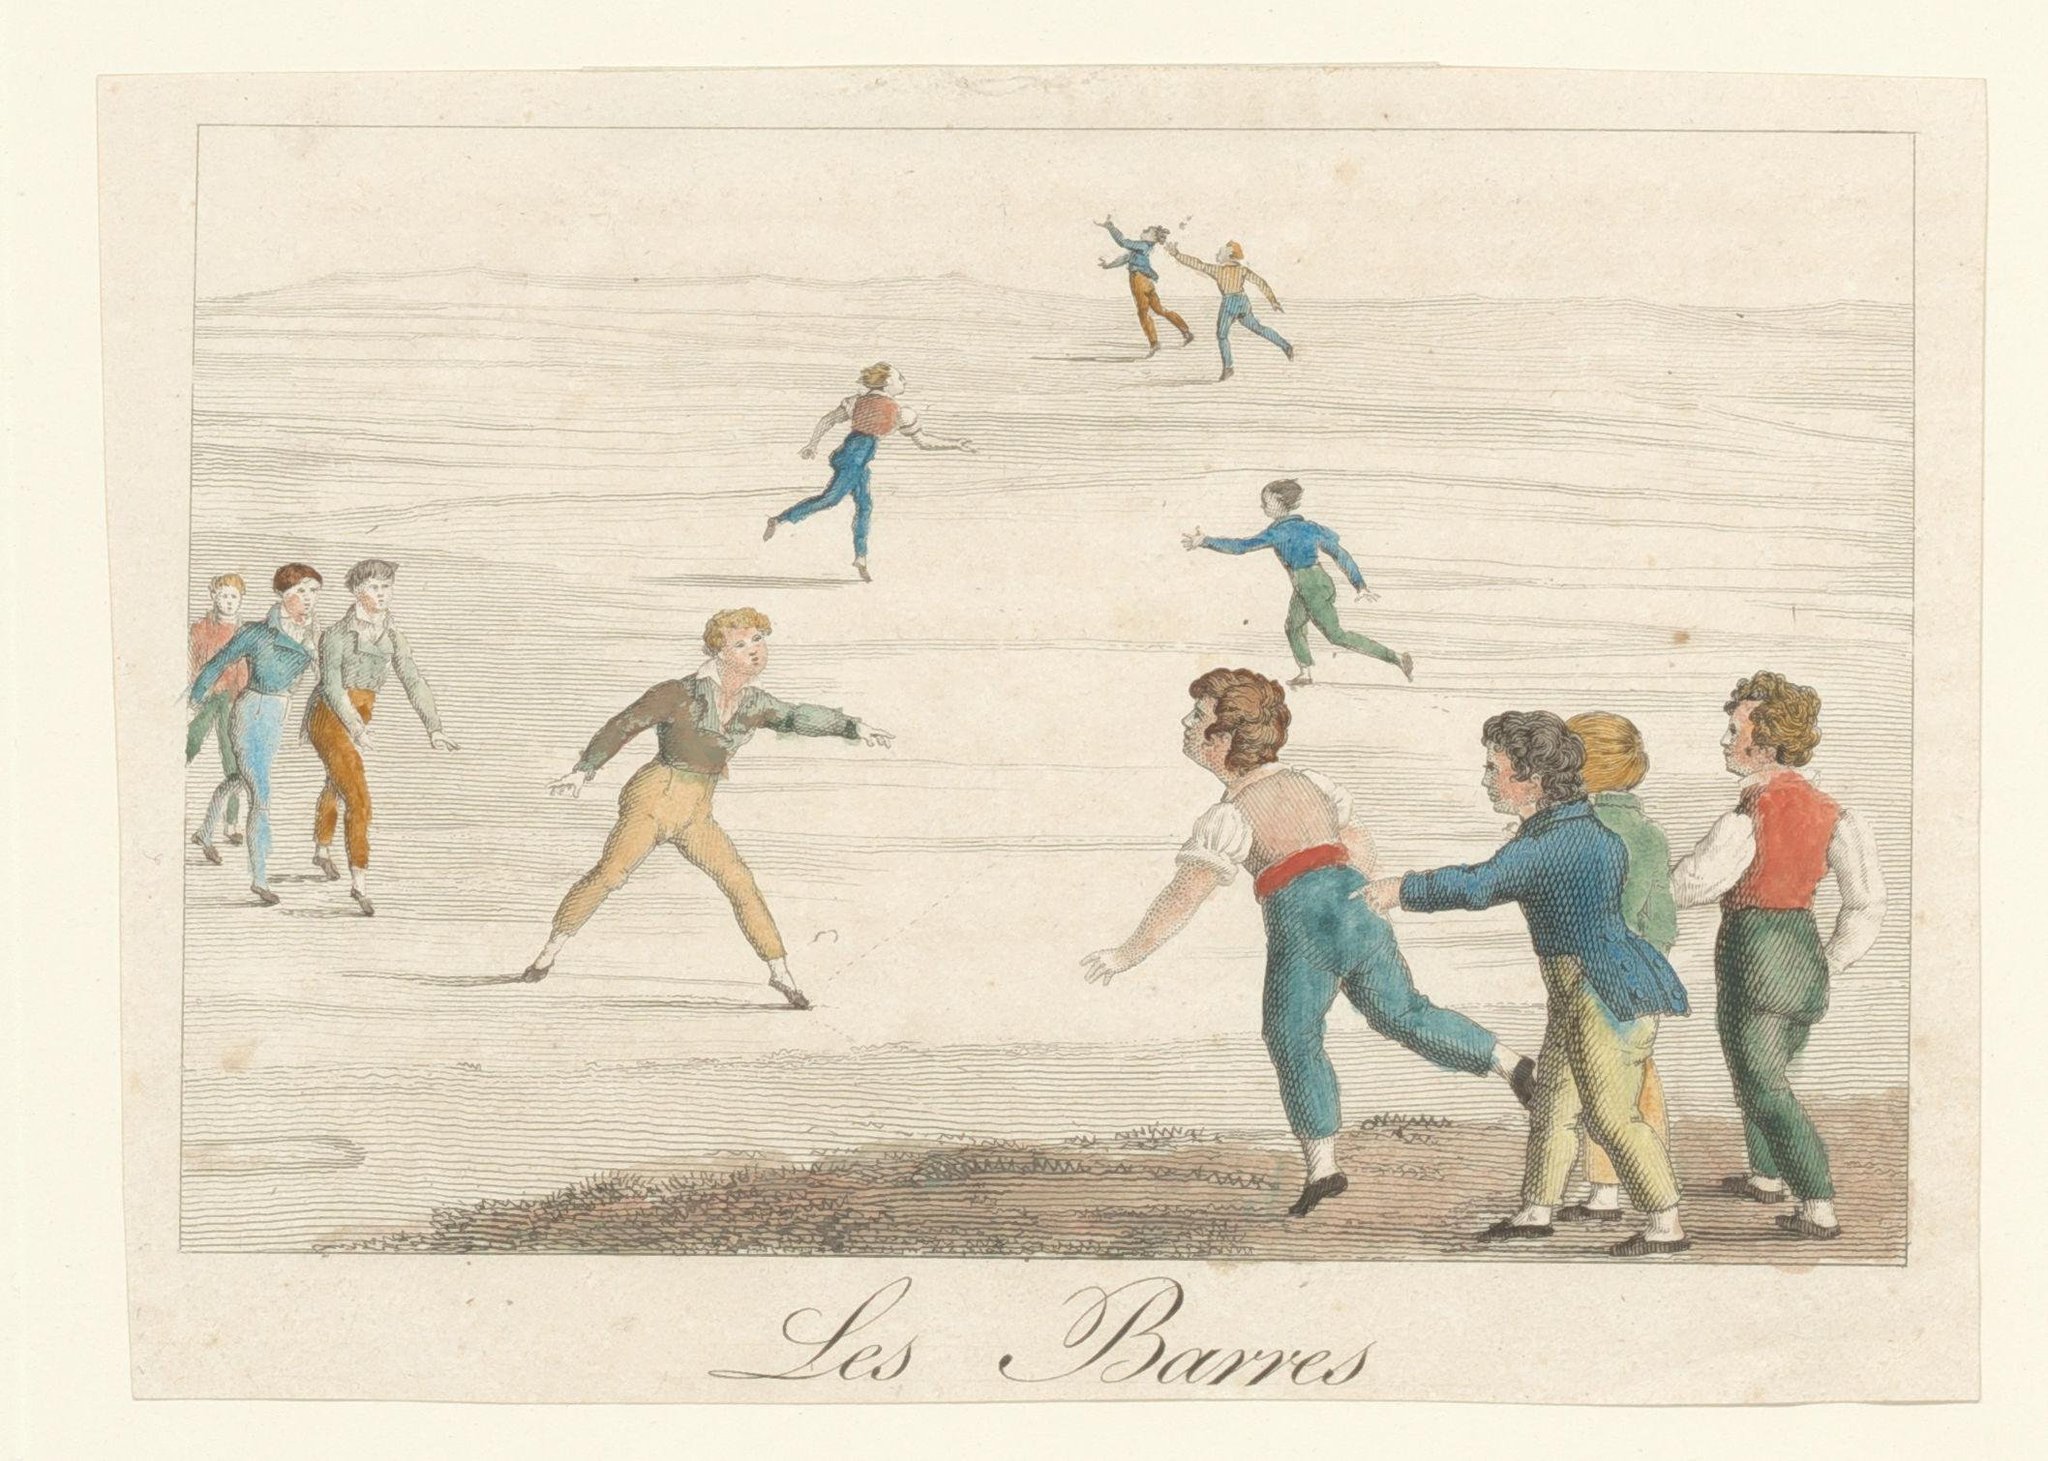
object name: print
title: Kinderen spelen een spel met de naam les barres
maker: Anonymous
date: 1800-1899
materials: paper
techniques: etching, hand coloring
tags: children's games and plays, child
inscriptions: collector's mark: Lugt 1641, stamp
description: Bij het stel spelen twee teams tegen elkaar en proberen elkaar gevangen te nemen. Onderwerpsrubrieken binnen de Atlas Zeden en Gewoonten: Zeden en Gewoonten in Engeren Zin, Des menschen beging, midden en einde, Kinderleven – Kinderspel en Kinderprenten.